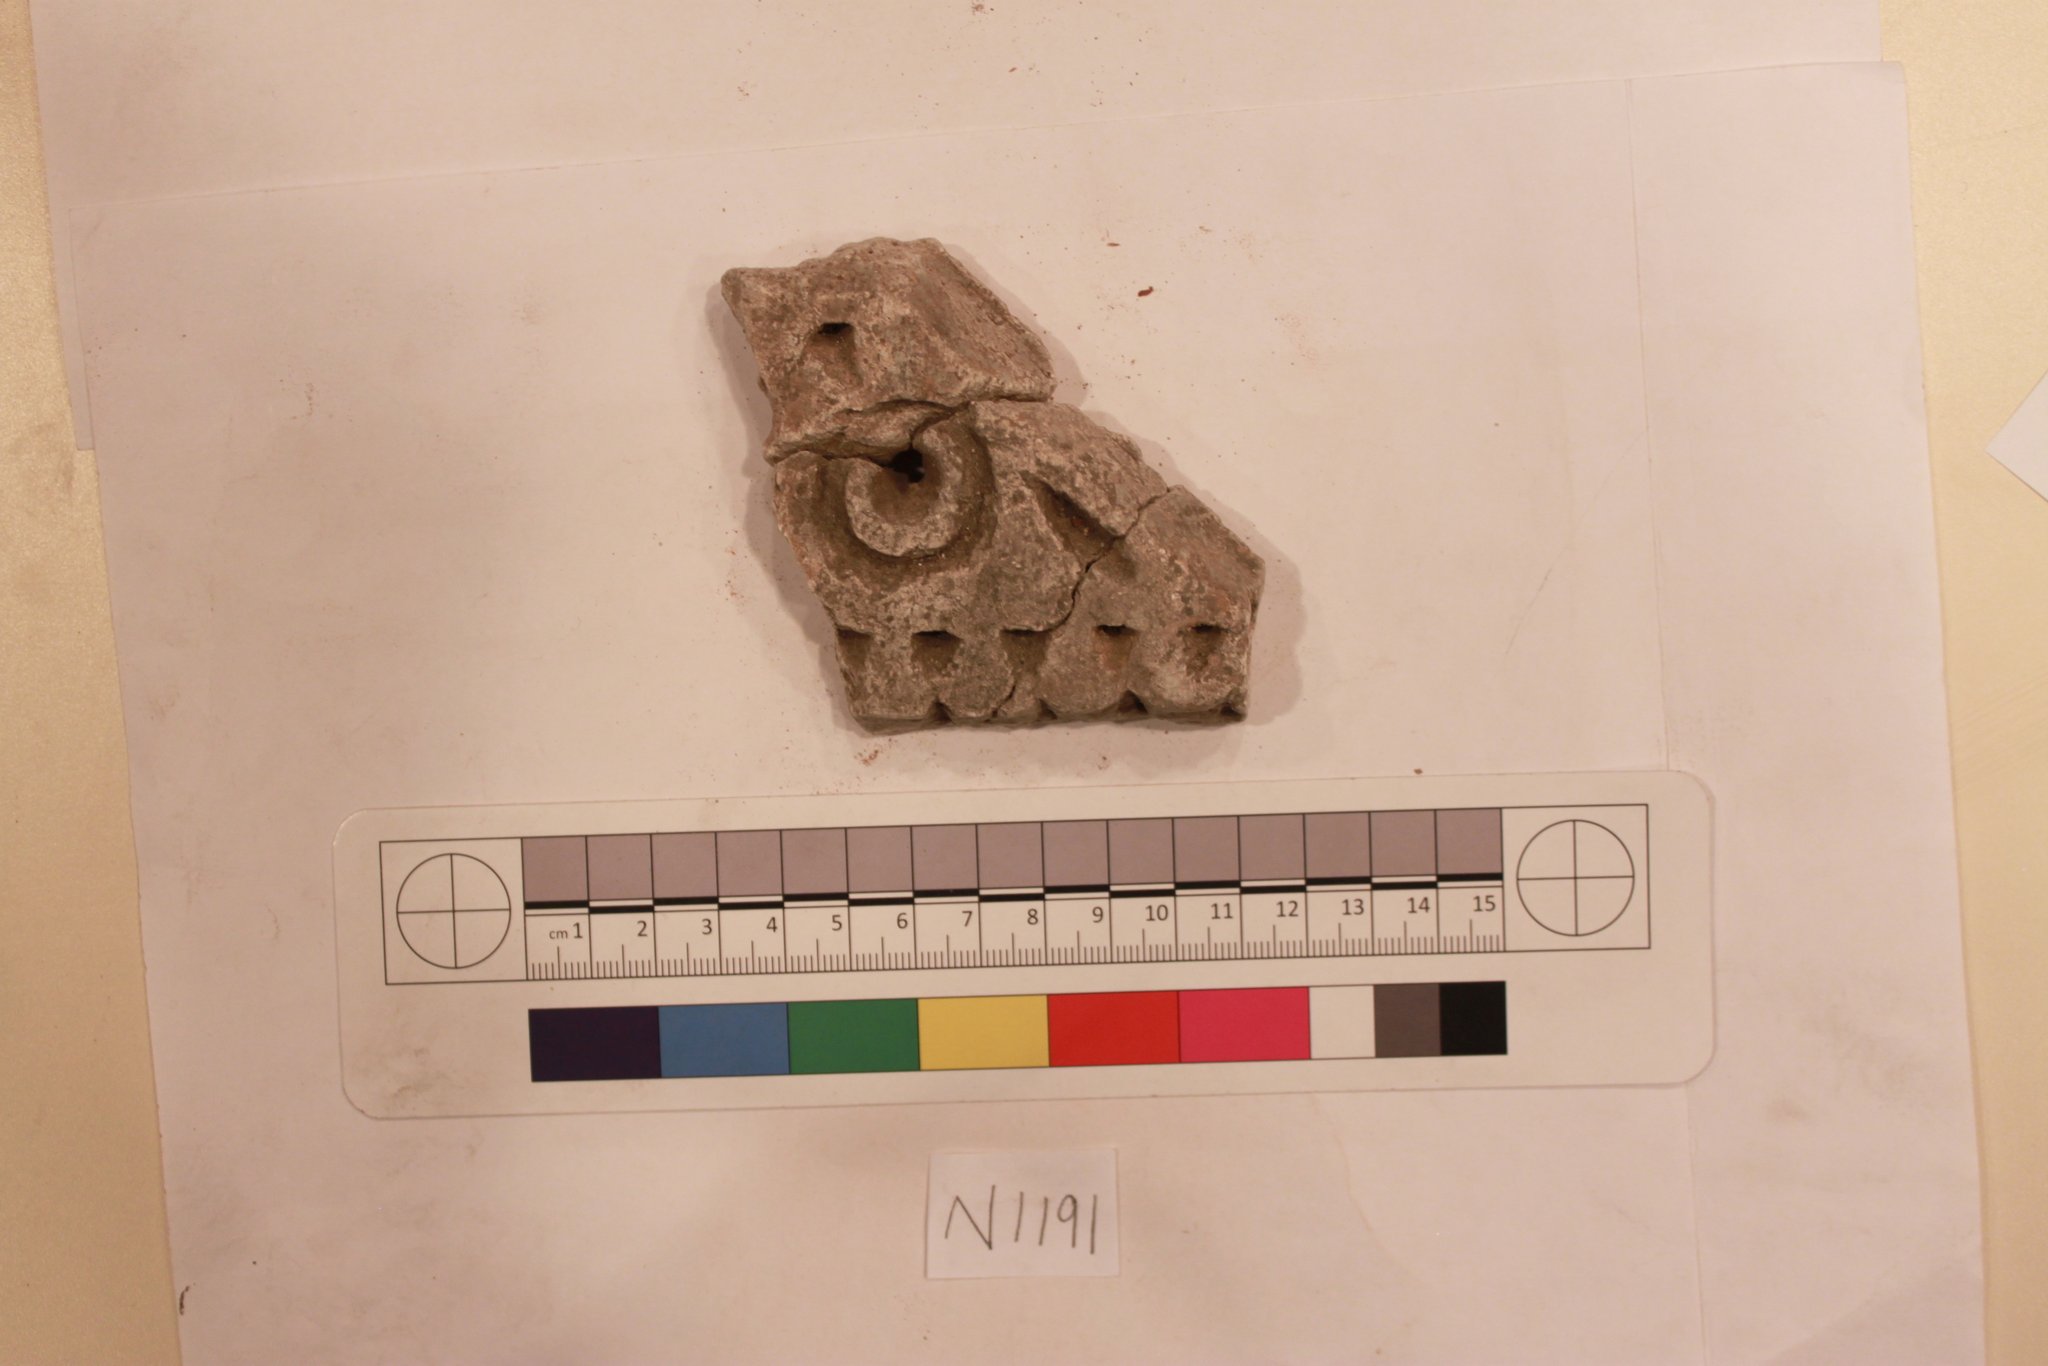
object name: fragment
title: Stucco Fragment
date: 701-1200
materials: plaster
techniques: carving, painting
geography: iran